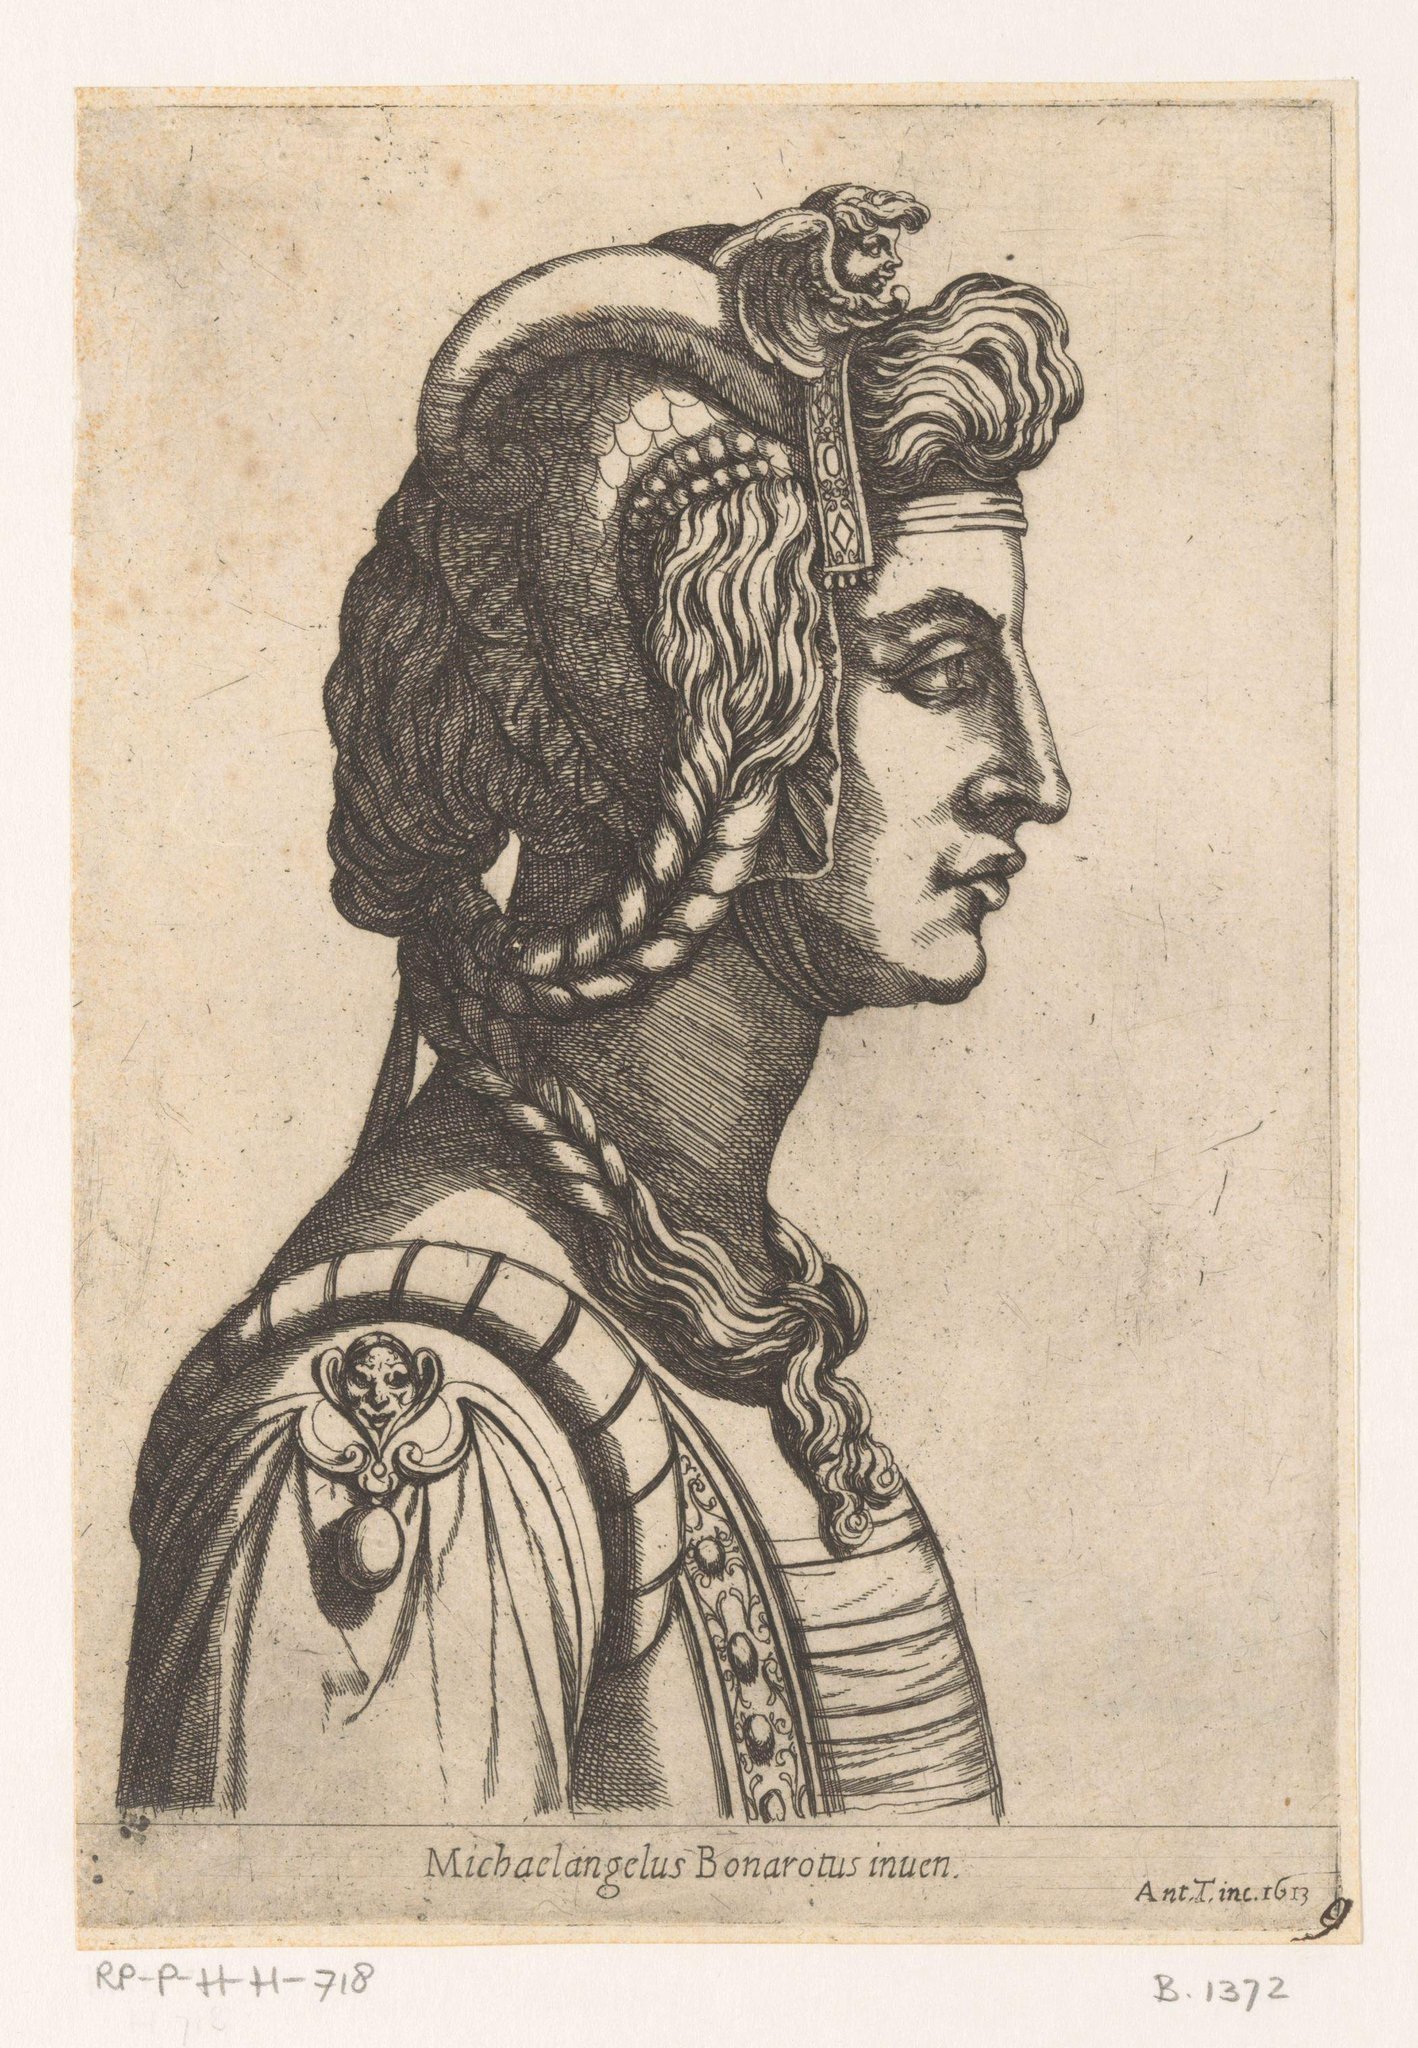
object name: print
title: Buste van vrouw met diadeem, naar rechts gewend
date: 1613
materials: paper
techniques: etching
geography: italy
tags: head (human) (+ sideview, profile), diadem, tiara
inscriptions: collector's mark: ‘Hinloopen’, collector's mark: Lugt 11, number: ‘9’